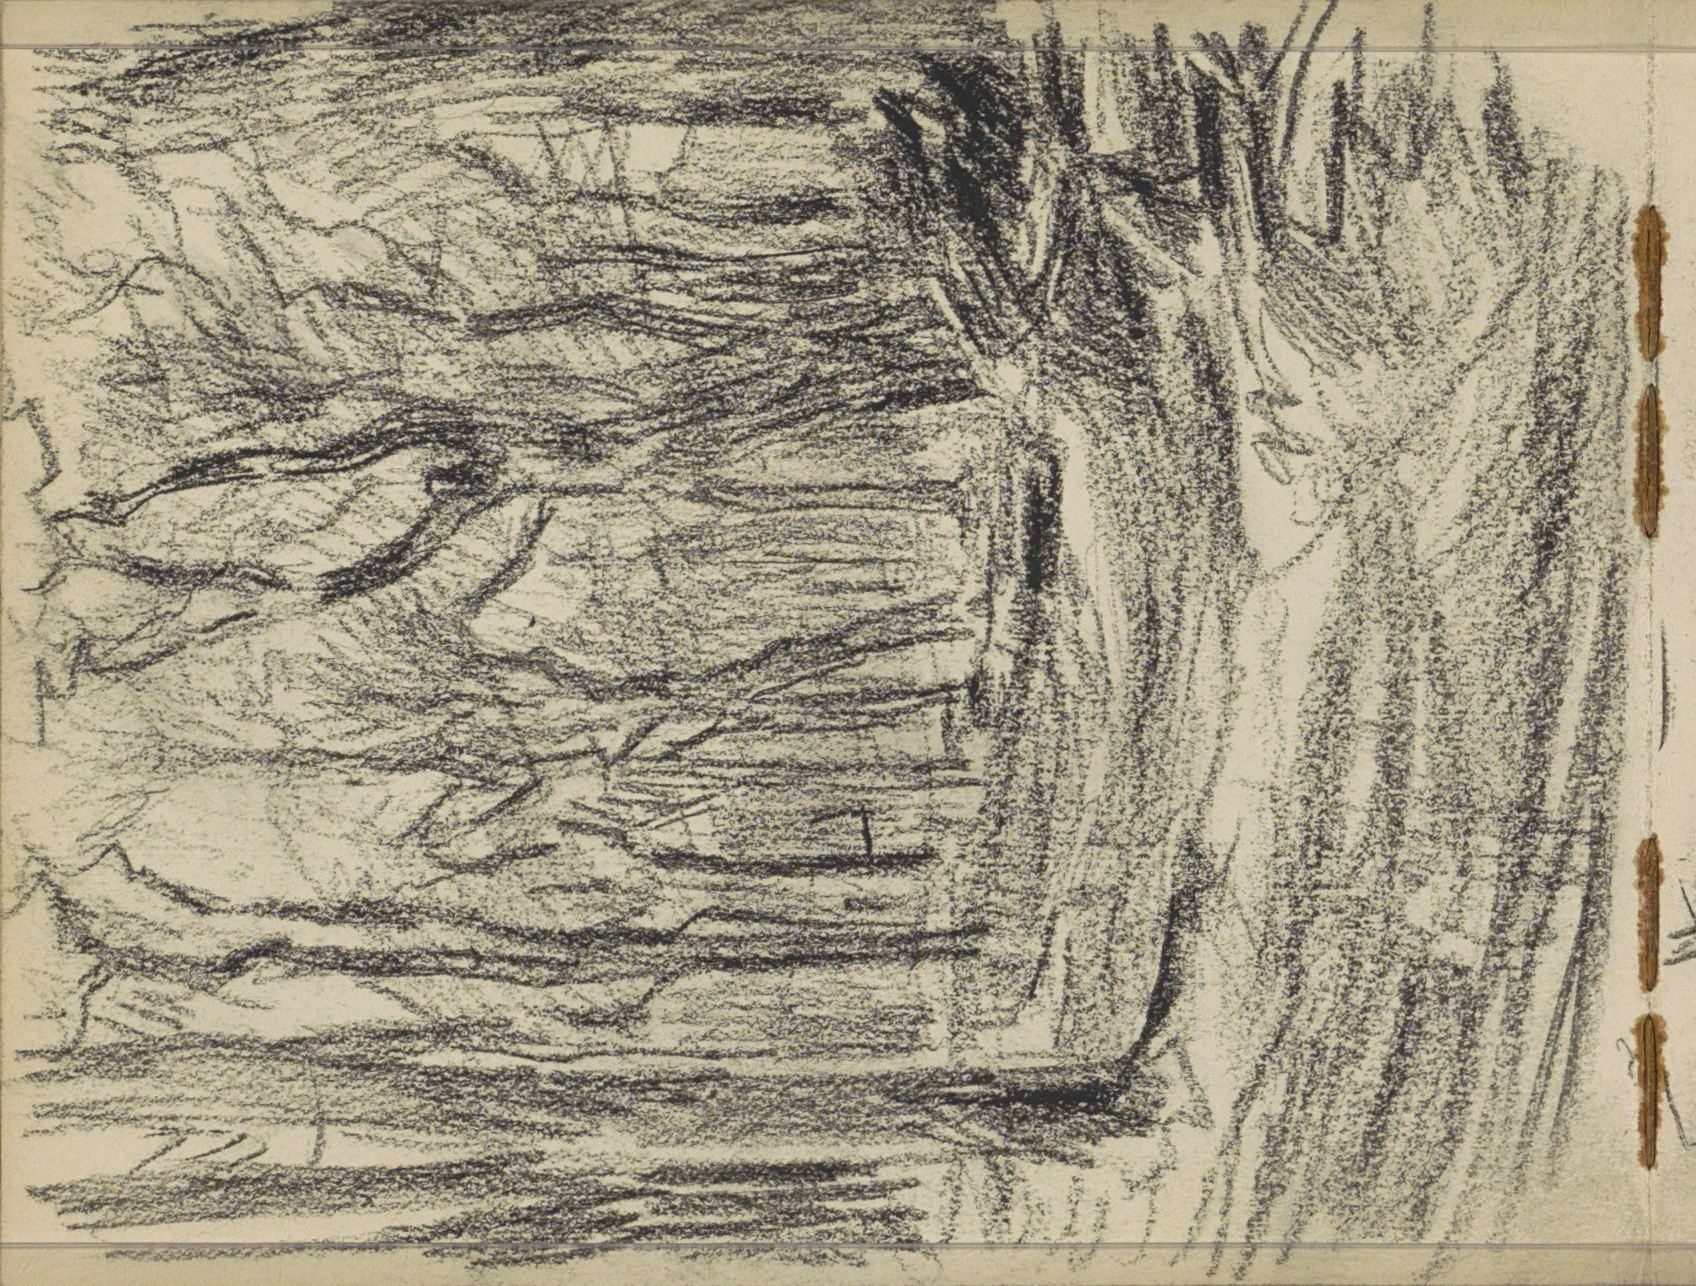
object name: sketchbook leaf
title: Bospad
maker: johan antonie de jonge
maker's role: draughtsman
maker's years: 1864-1927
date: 1881-1927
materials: chalk, paper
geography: south holland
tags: forest path or lane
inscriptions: kleurnotitie, handgeschreven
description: Bospad. Blad 14 verso uit een schetsboek met 34 bladen.